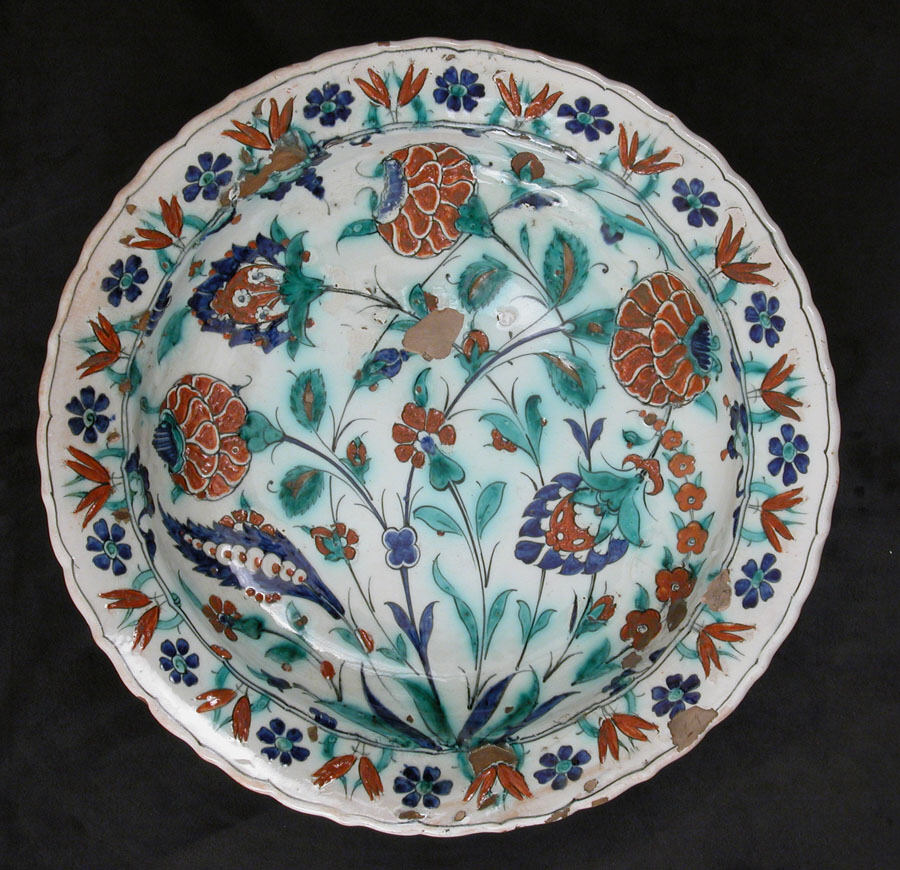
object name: dish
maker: cantagalli of florence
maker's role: manufacturer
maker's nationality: italian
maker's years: 1878-1978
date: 1801-1900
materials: stonepaste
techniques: glazing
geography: italy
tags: flowers,leaves